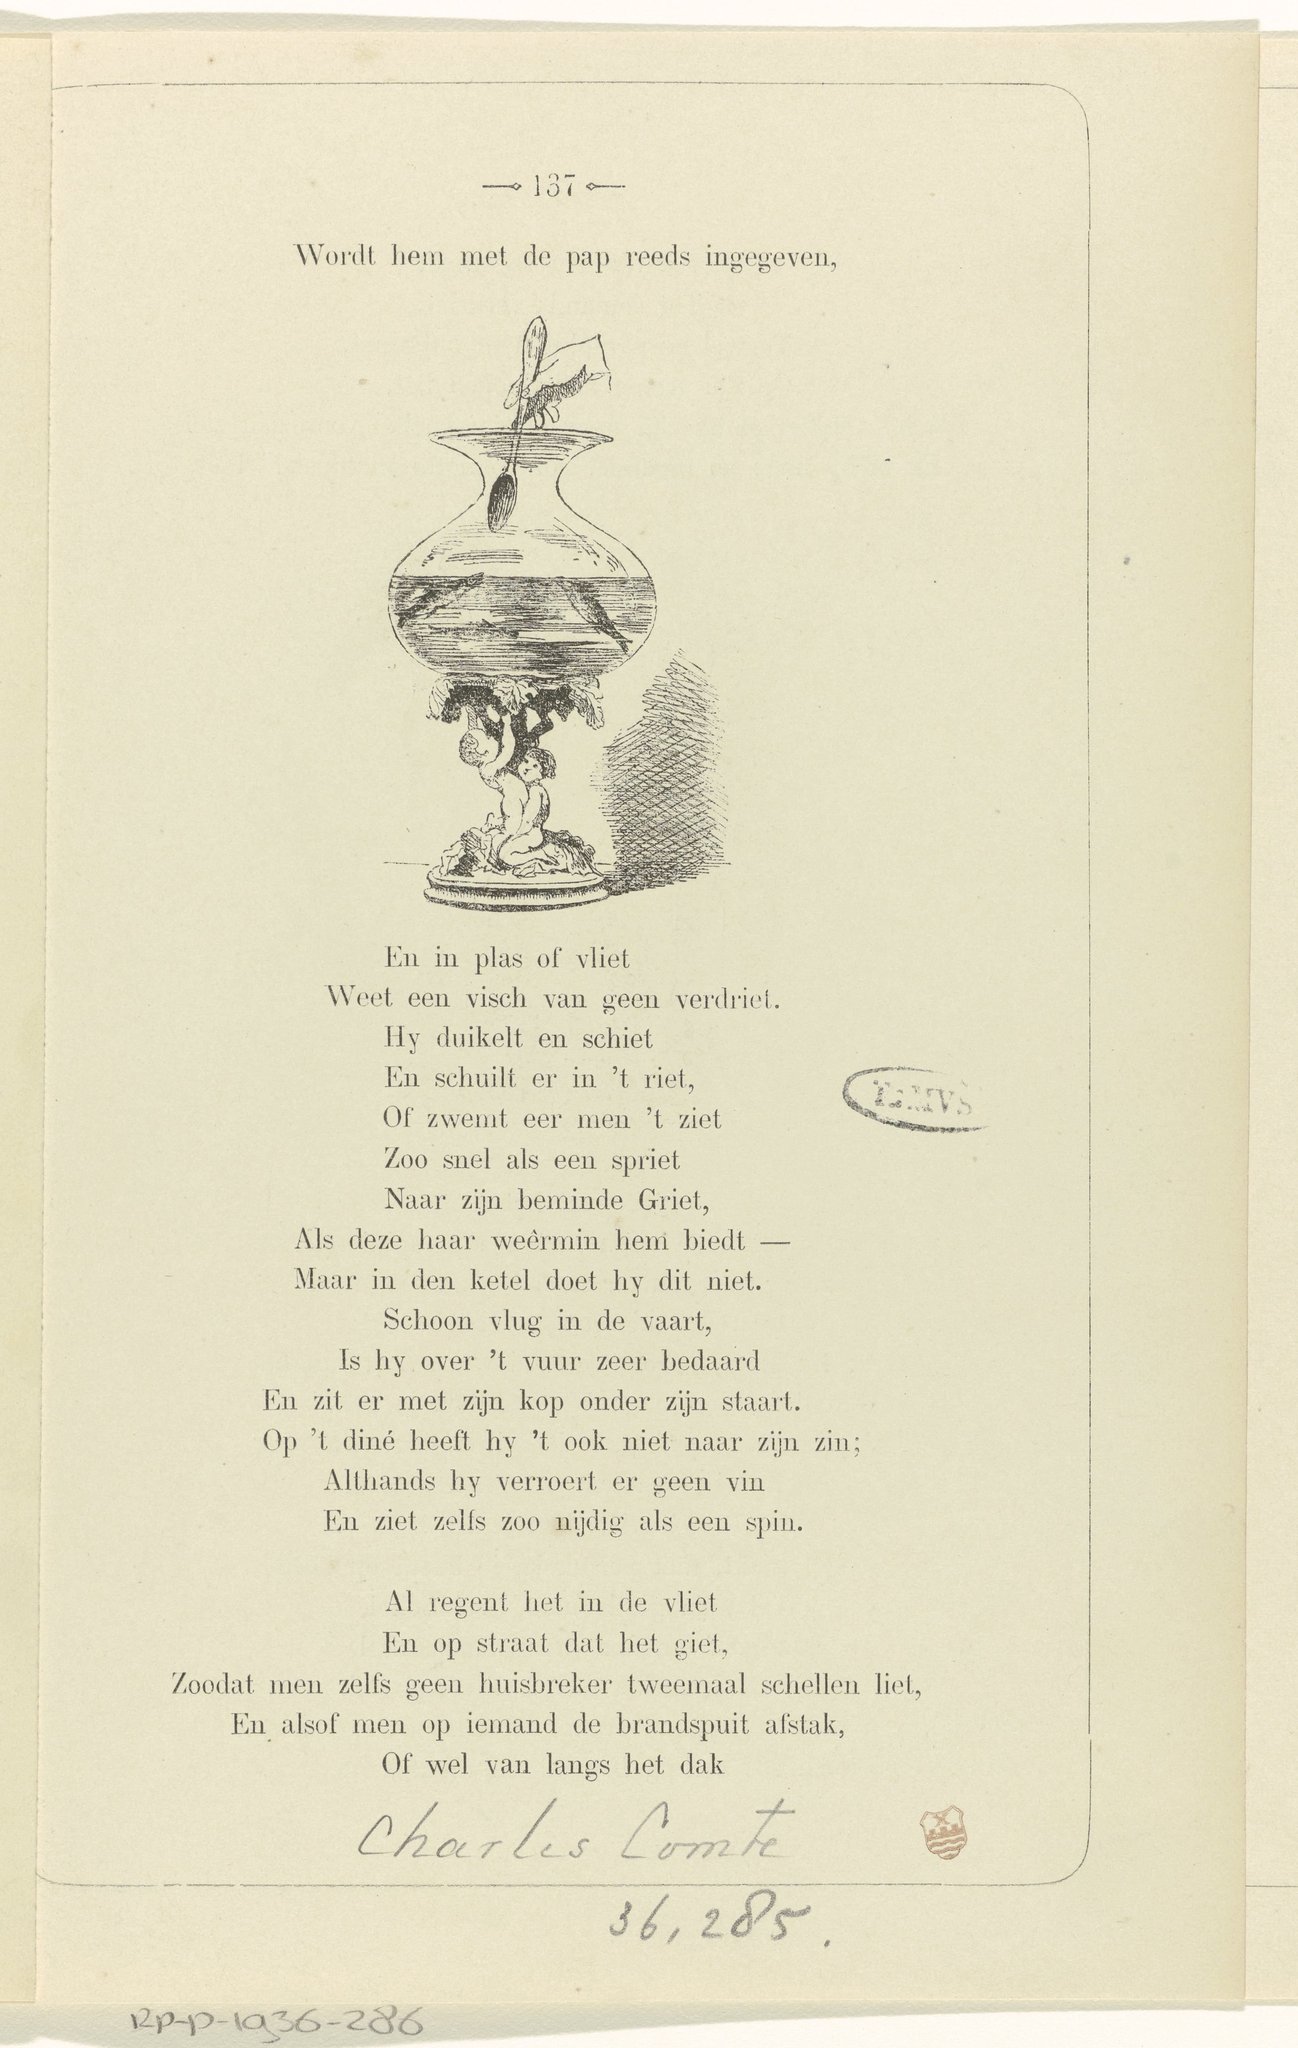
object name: print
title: Natuurlijke historie voor de jeugd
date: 1872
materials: paper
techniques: letterpress printing, engraving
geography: netherlands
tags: teacher and pupil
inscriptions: collector's mark: Lugt 2228, collector's mark: Lugt 2760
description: Prent uit: Schoolmeester, De. De gedichten van den Schoolmeester. Amsterdam: Jacob van Lennep, 1872.